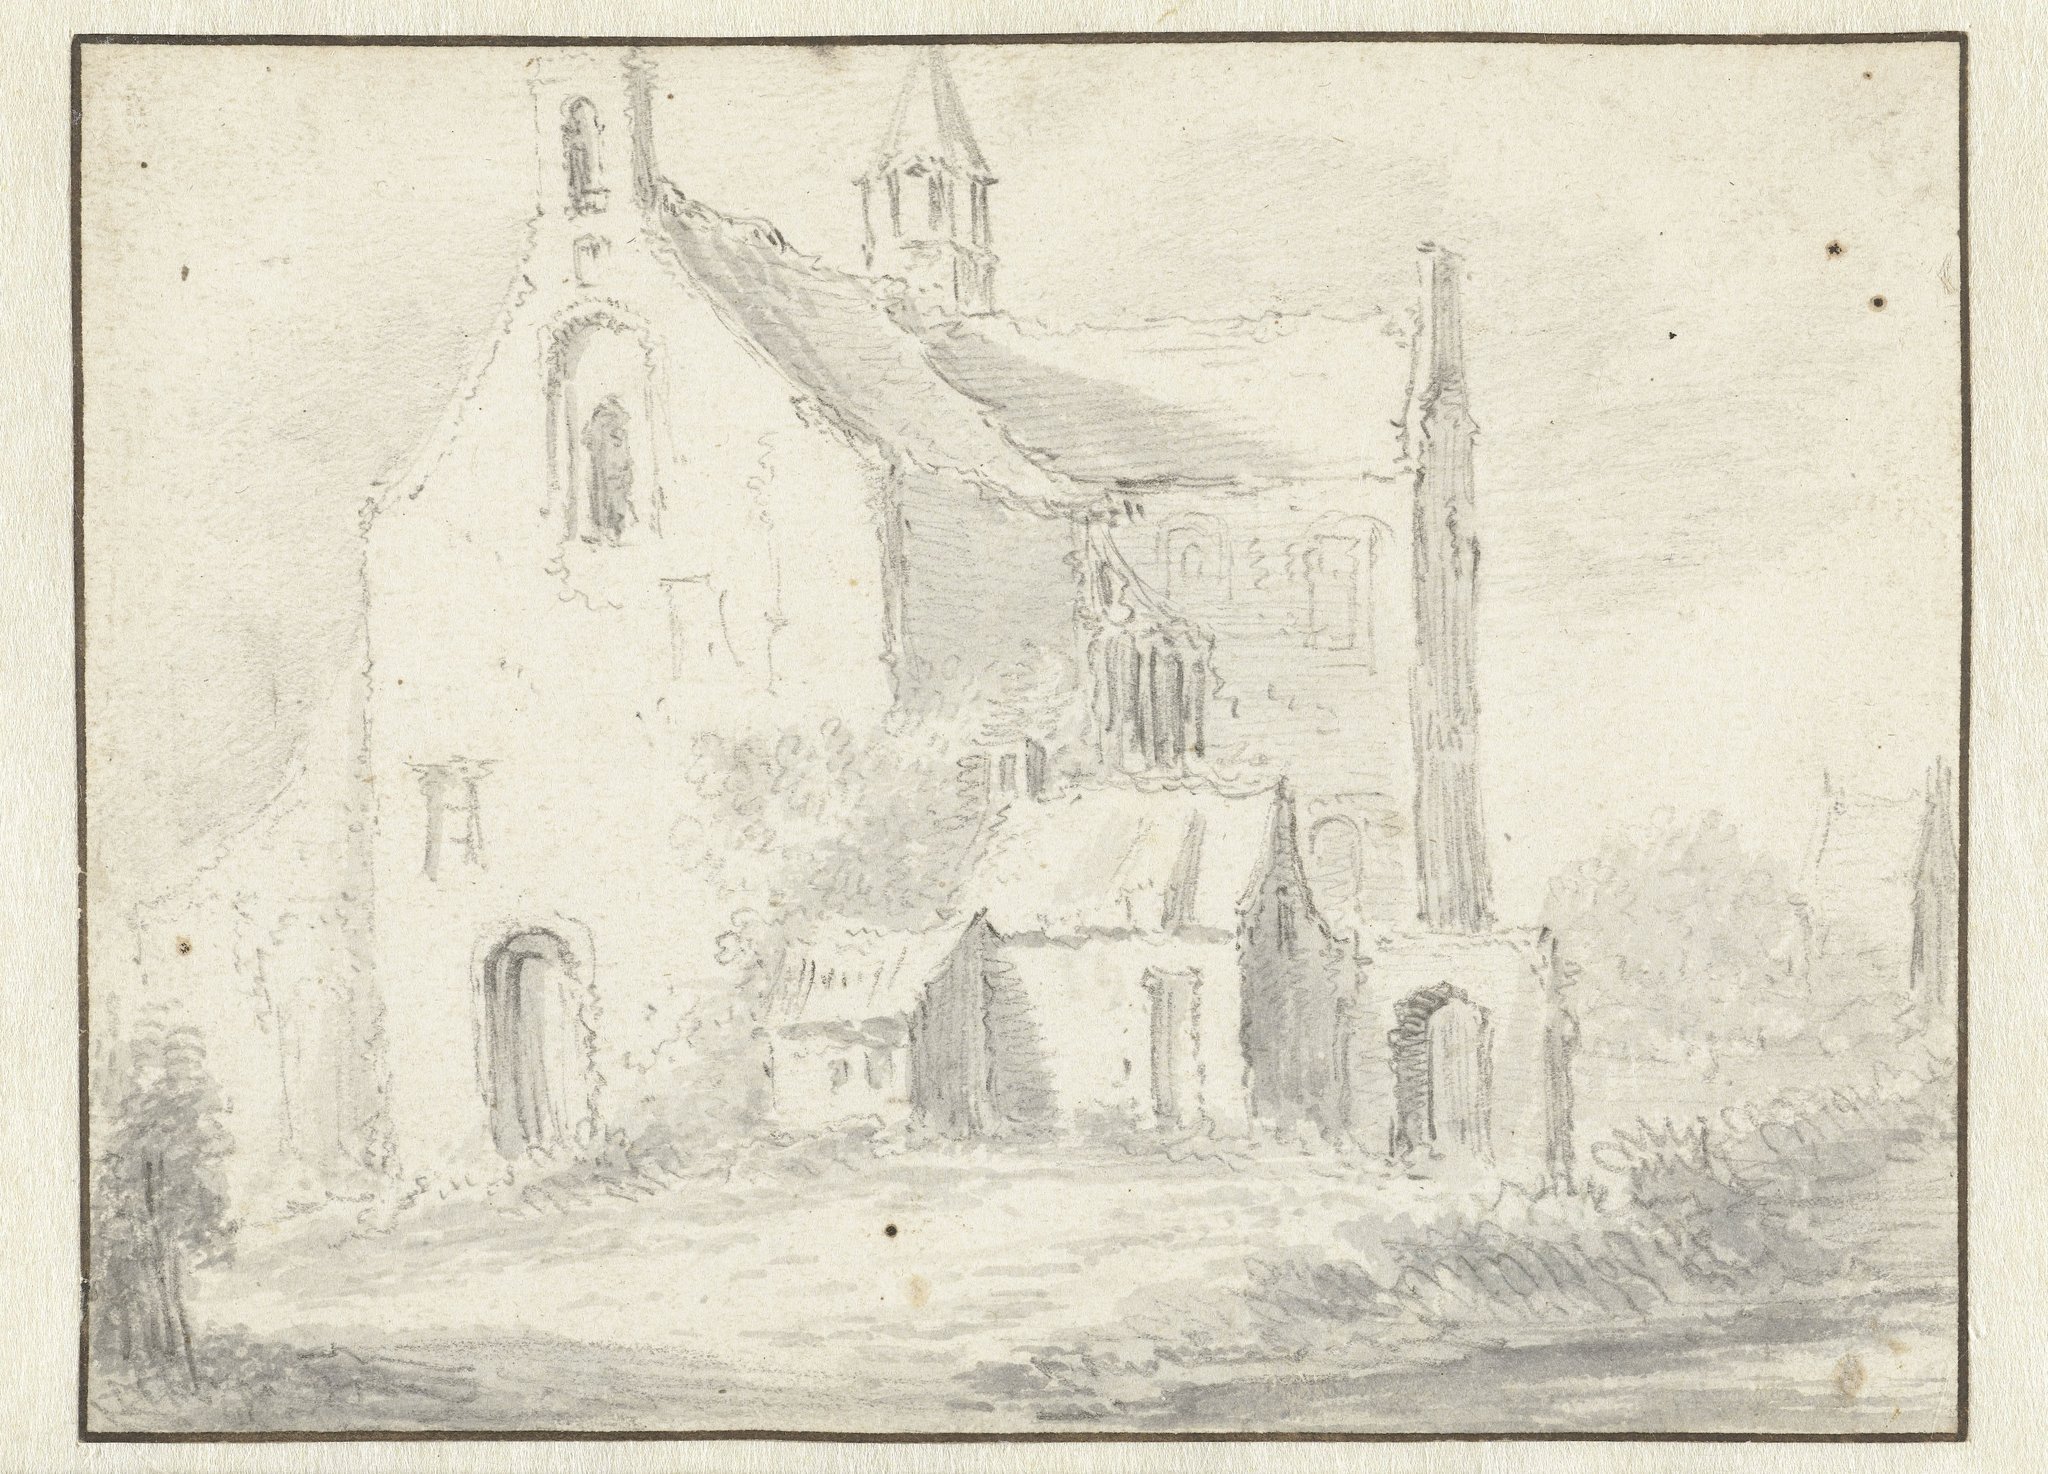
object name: drawing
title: Romaanse kerk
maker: salomon van ruysdael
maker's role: draughtsman, painter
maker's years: 1600-1670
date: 1610-1670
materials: chalk, paper, pencil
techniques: brush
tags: church (exterior)